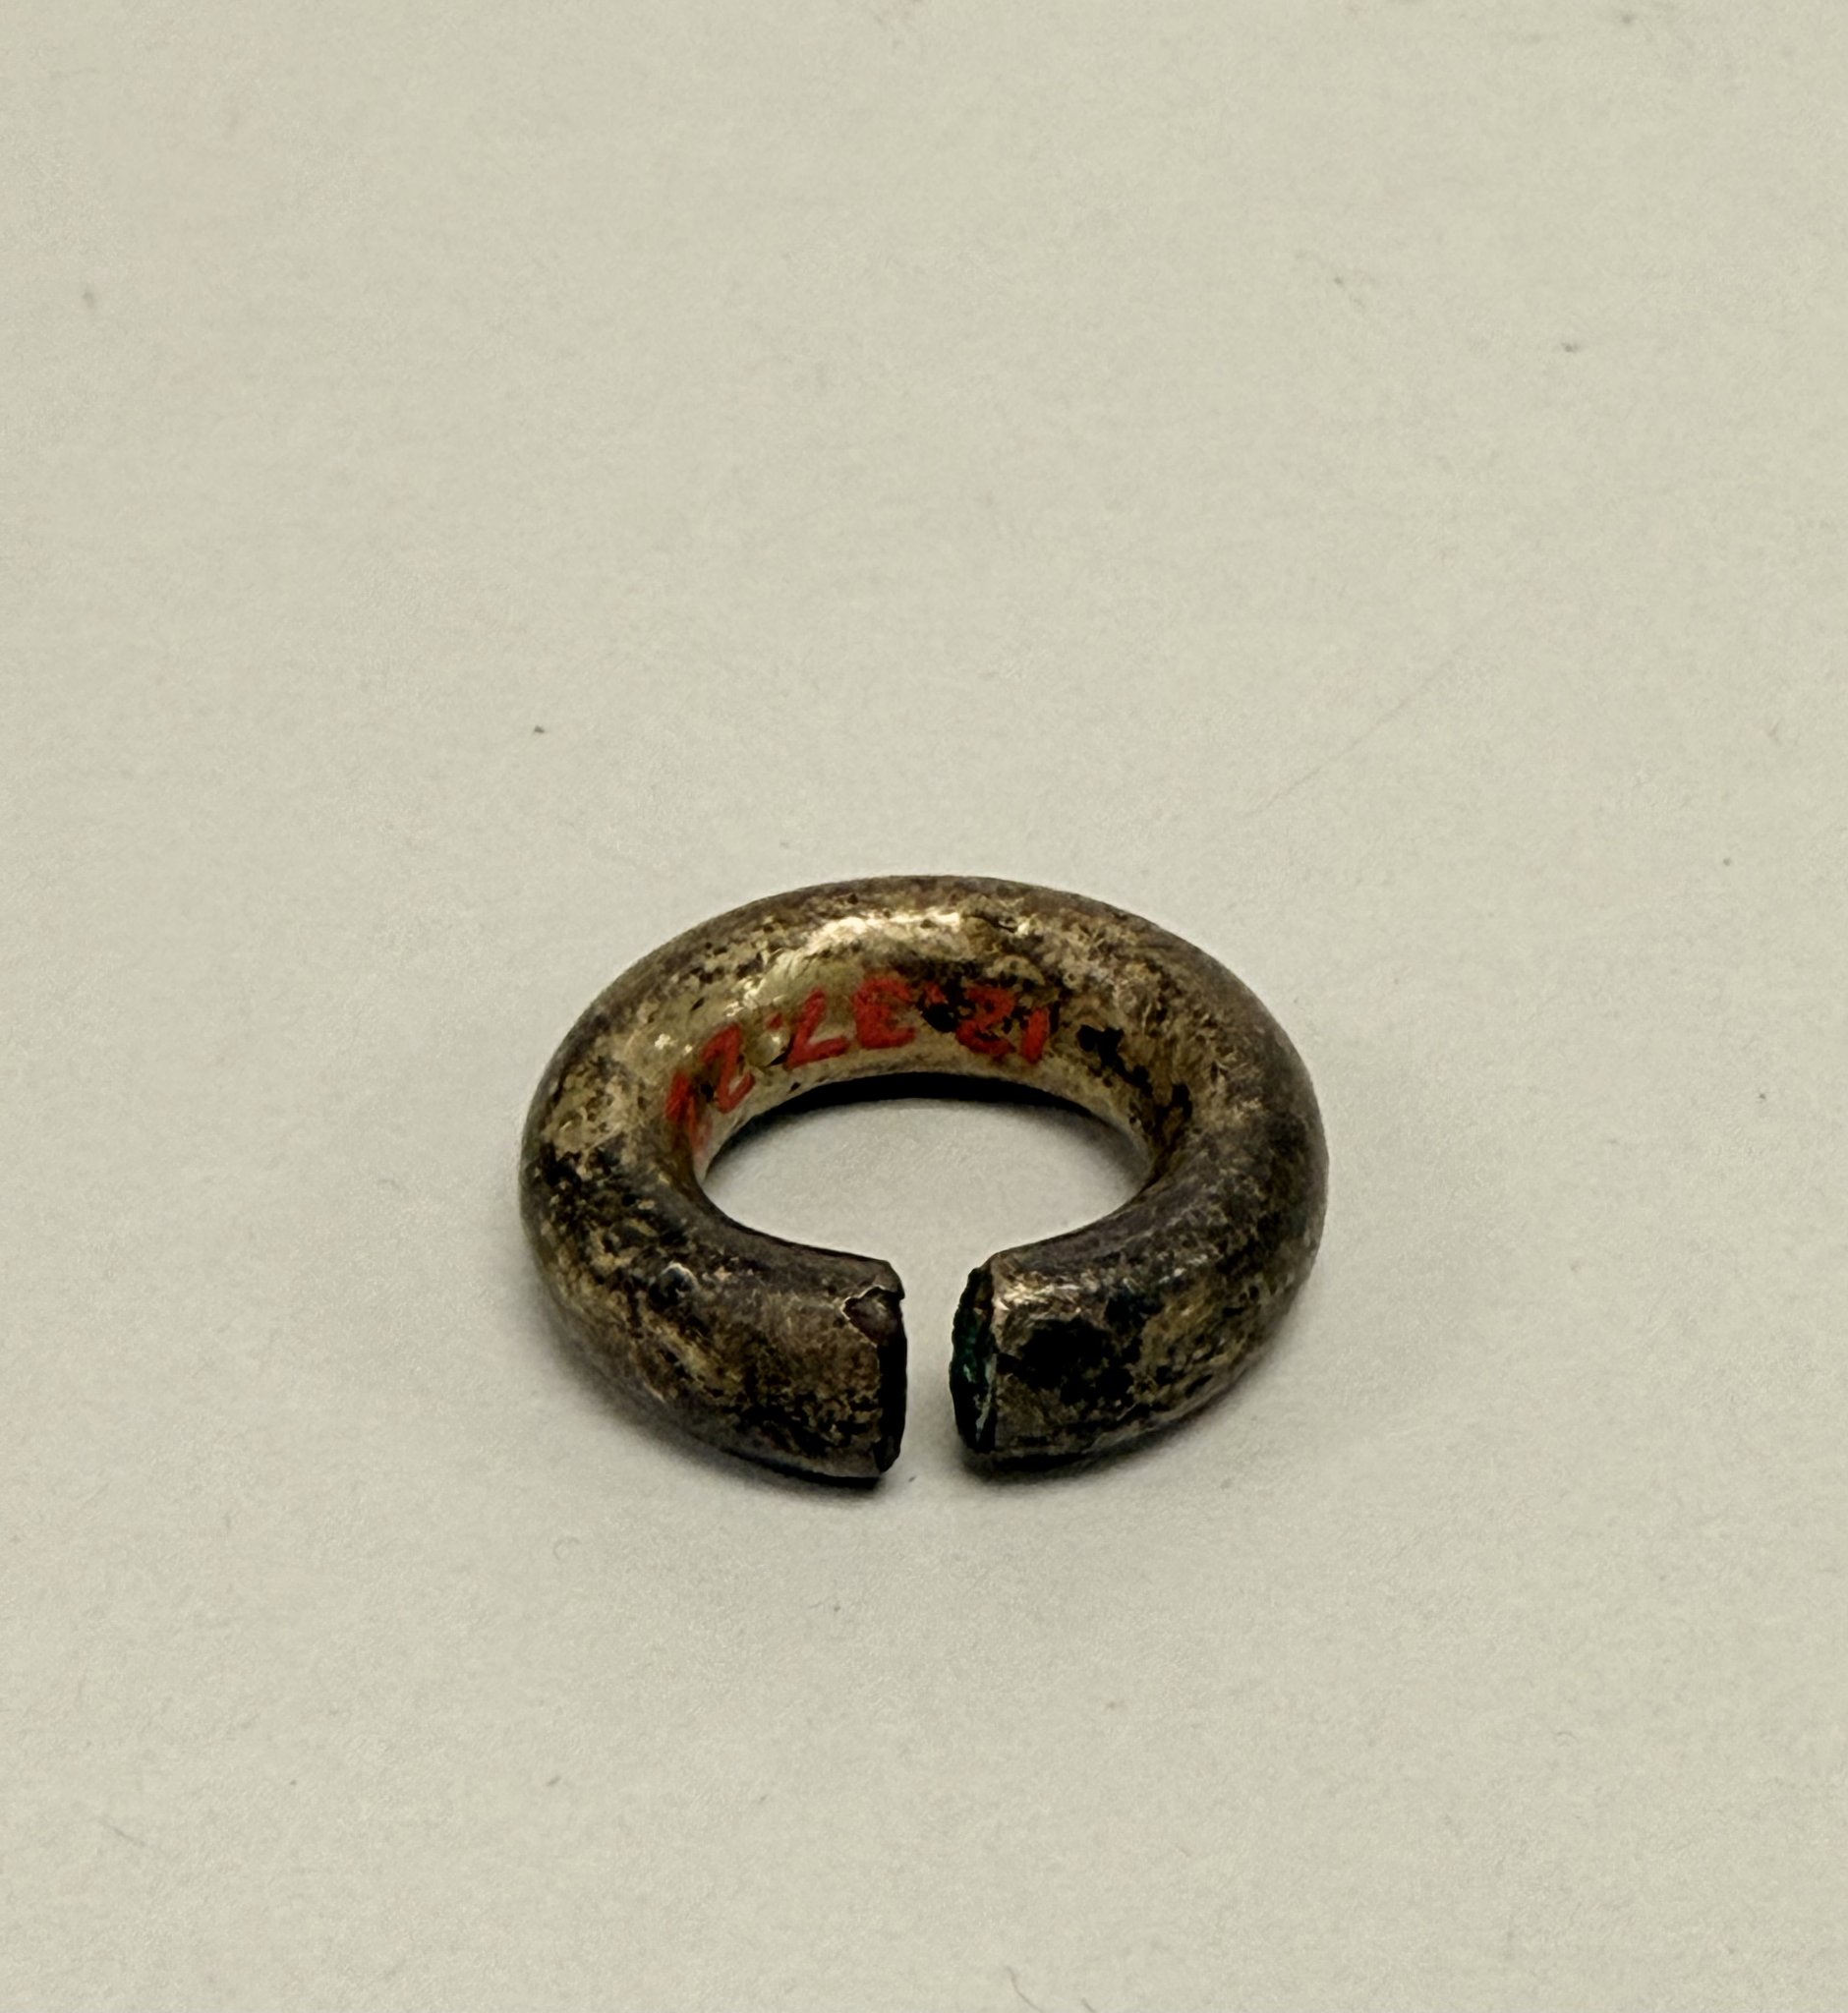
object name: earring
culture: japanese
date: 601-700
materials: metal